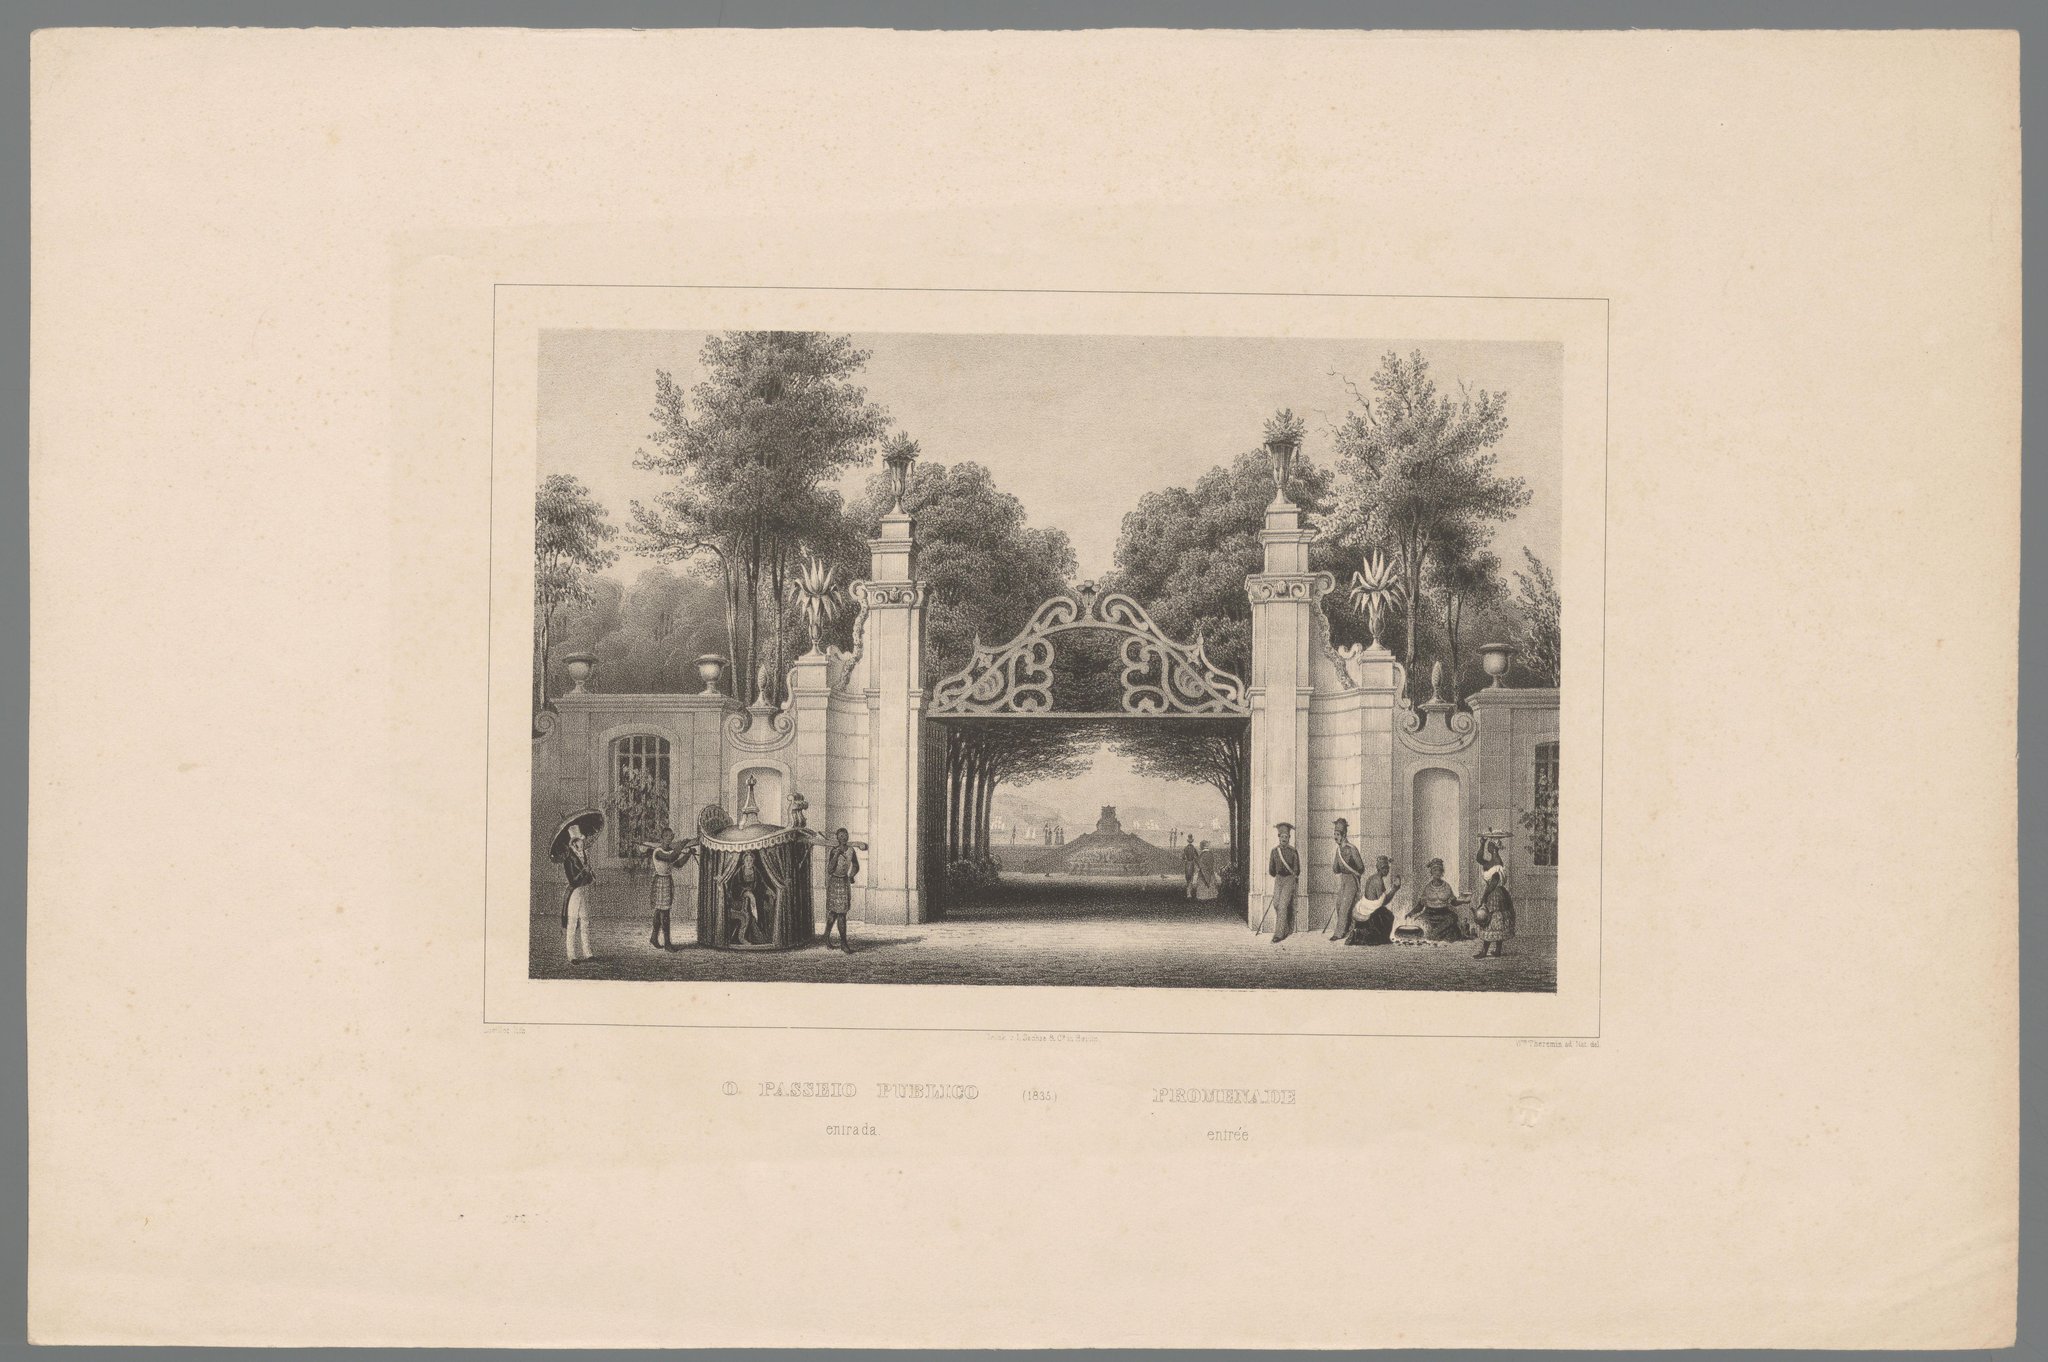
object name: print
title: O Passeio Publico / Promenade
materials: paper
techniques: lithograph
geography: berlin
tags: square, place, circus, etc., park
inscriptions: collector's mark: Lugt 2228, check stamp: ‘T’